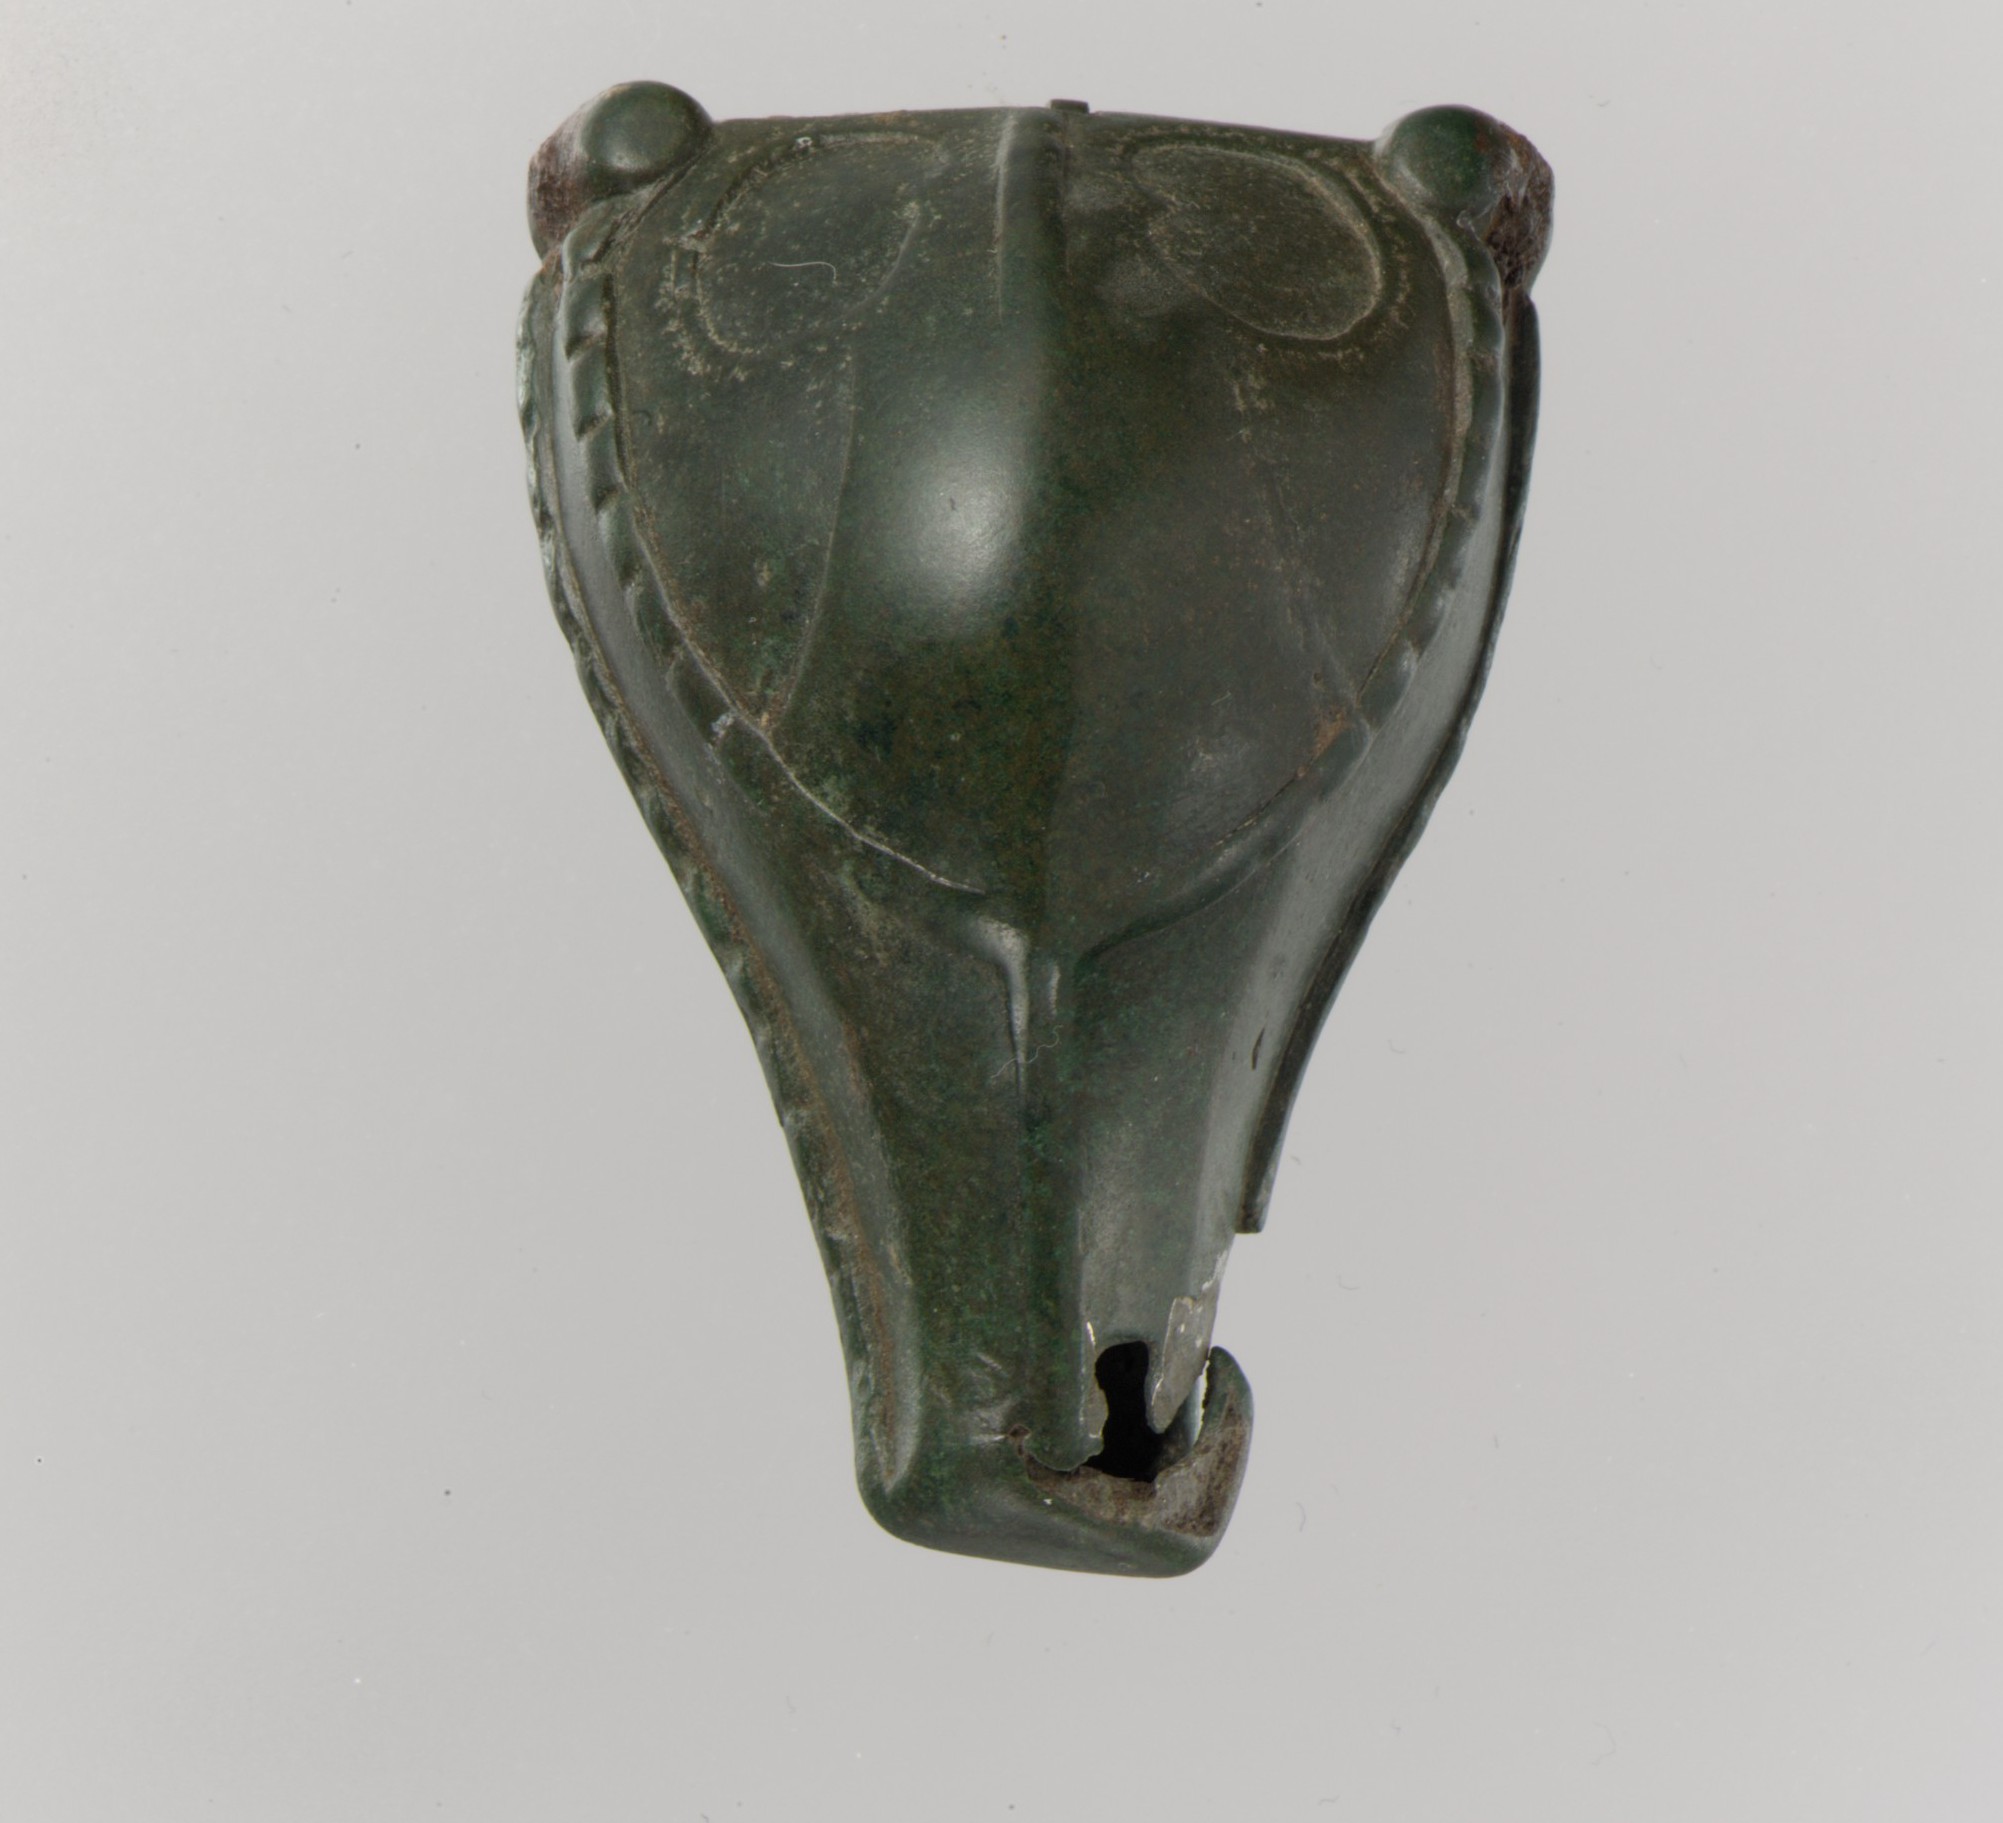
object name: brooch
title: Brooch with Boar’s-Head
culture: vendel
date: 767-800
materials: copper alloy, gilt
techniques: casting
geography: sweden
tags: boars